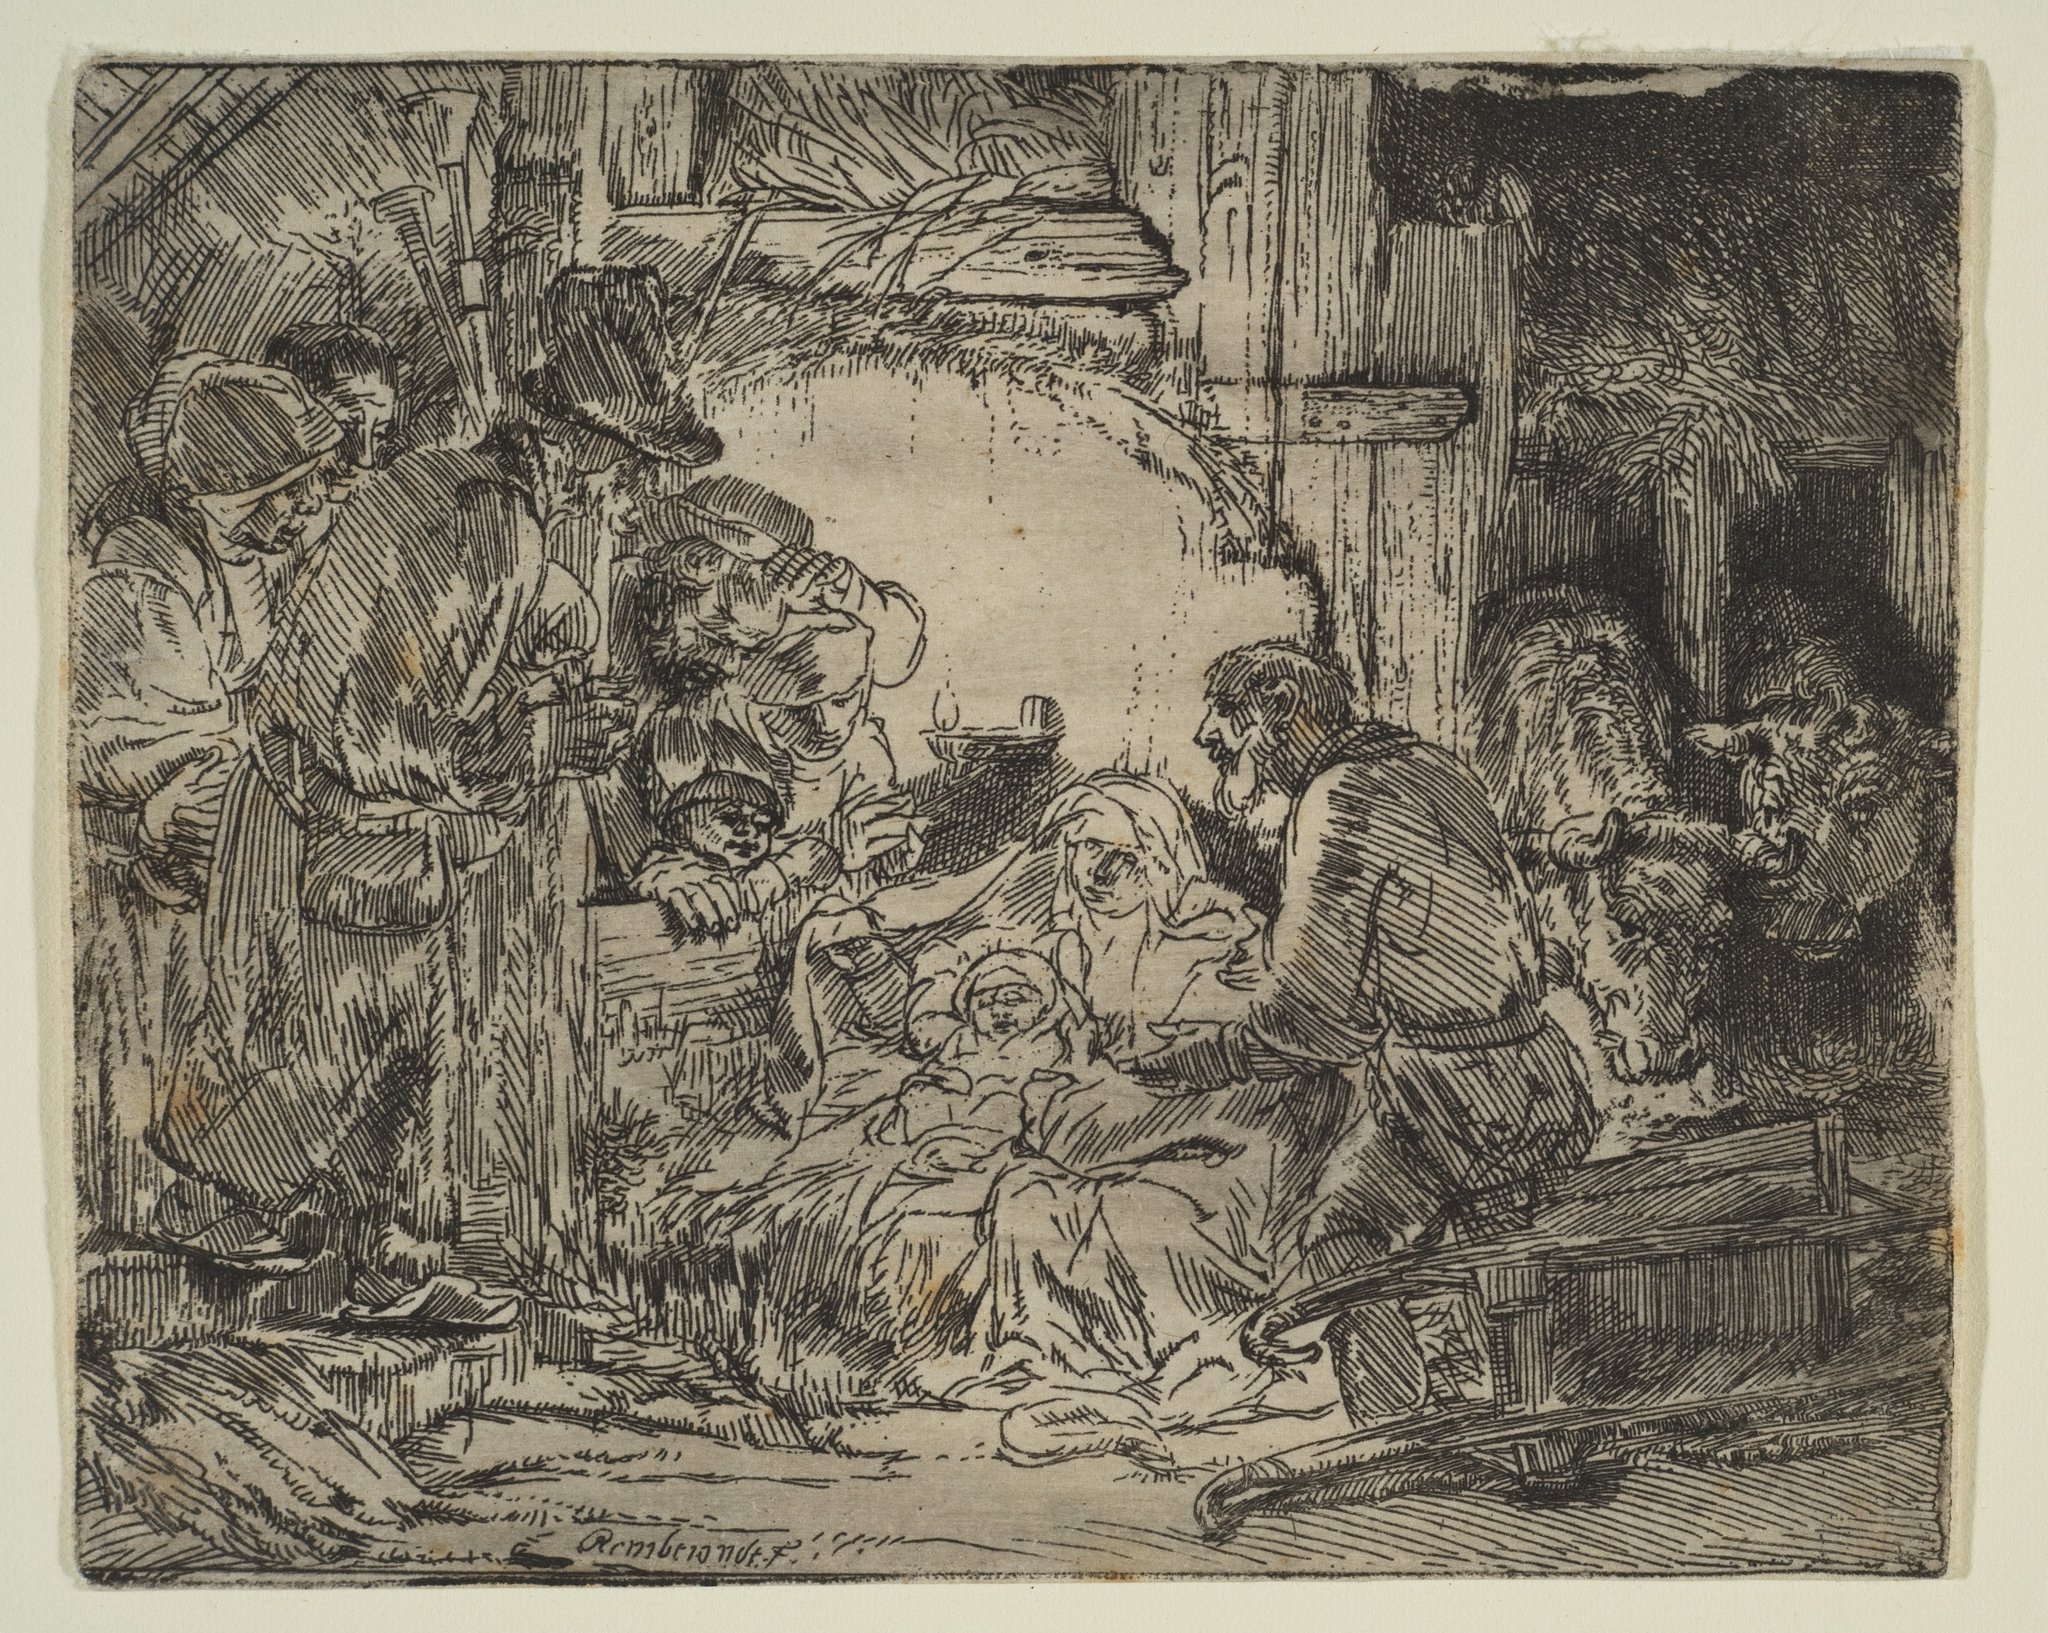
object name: print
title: The Adoration of the Shepherds: with the Lamp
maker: rembrandt van rijn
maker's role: artist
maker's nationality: dutch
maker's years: 1606-1669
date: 1649-1659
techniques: drypoint, etching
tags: animals,jesus,adoration of the shepherds